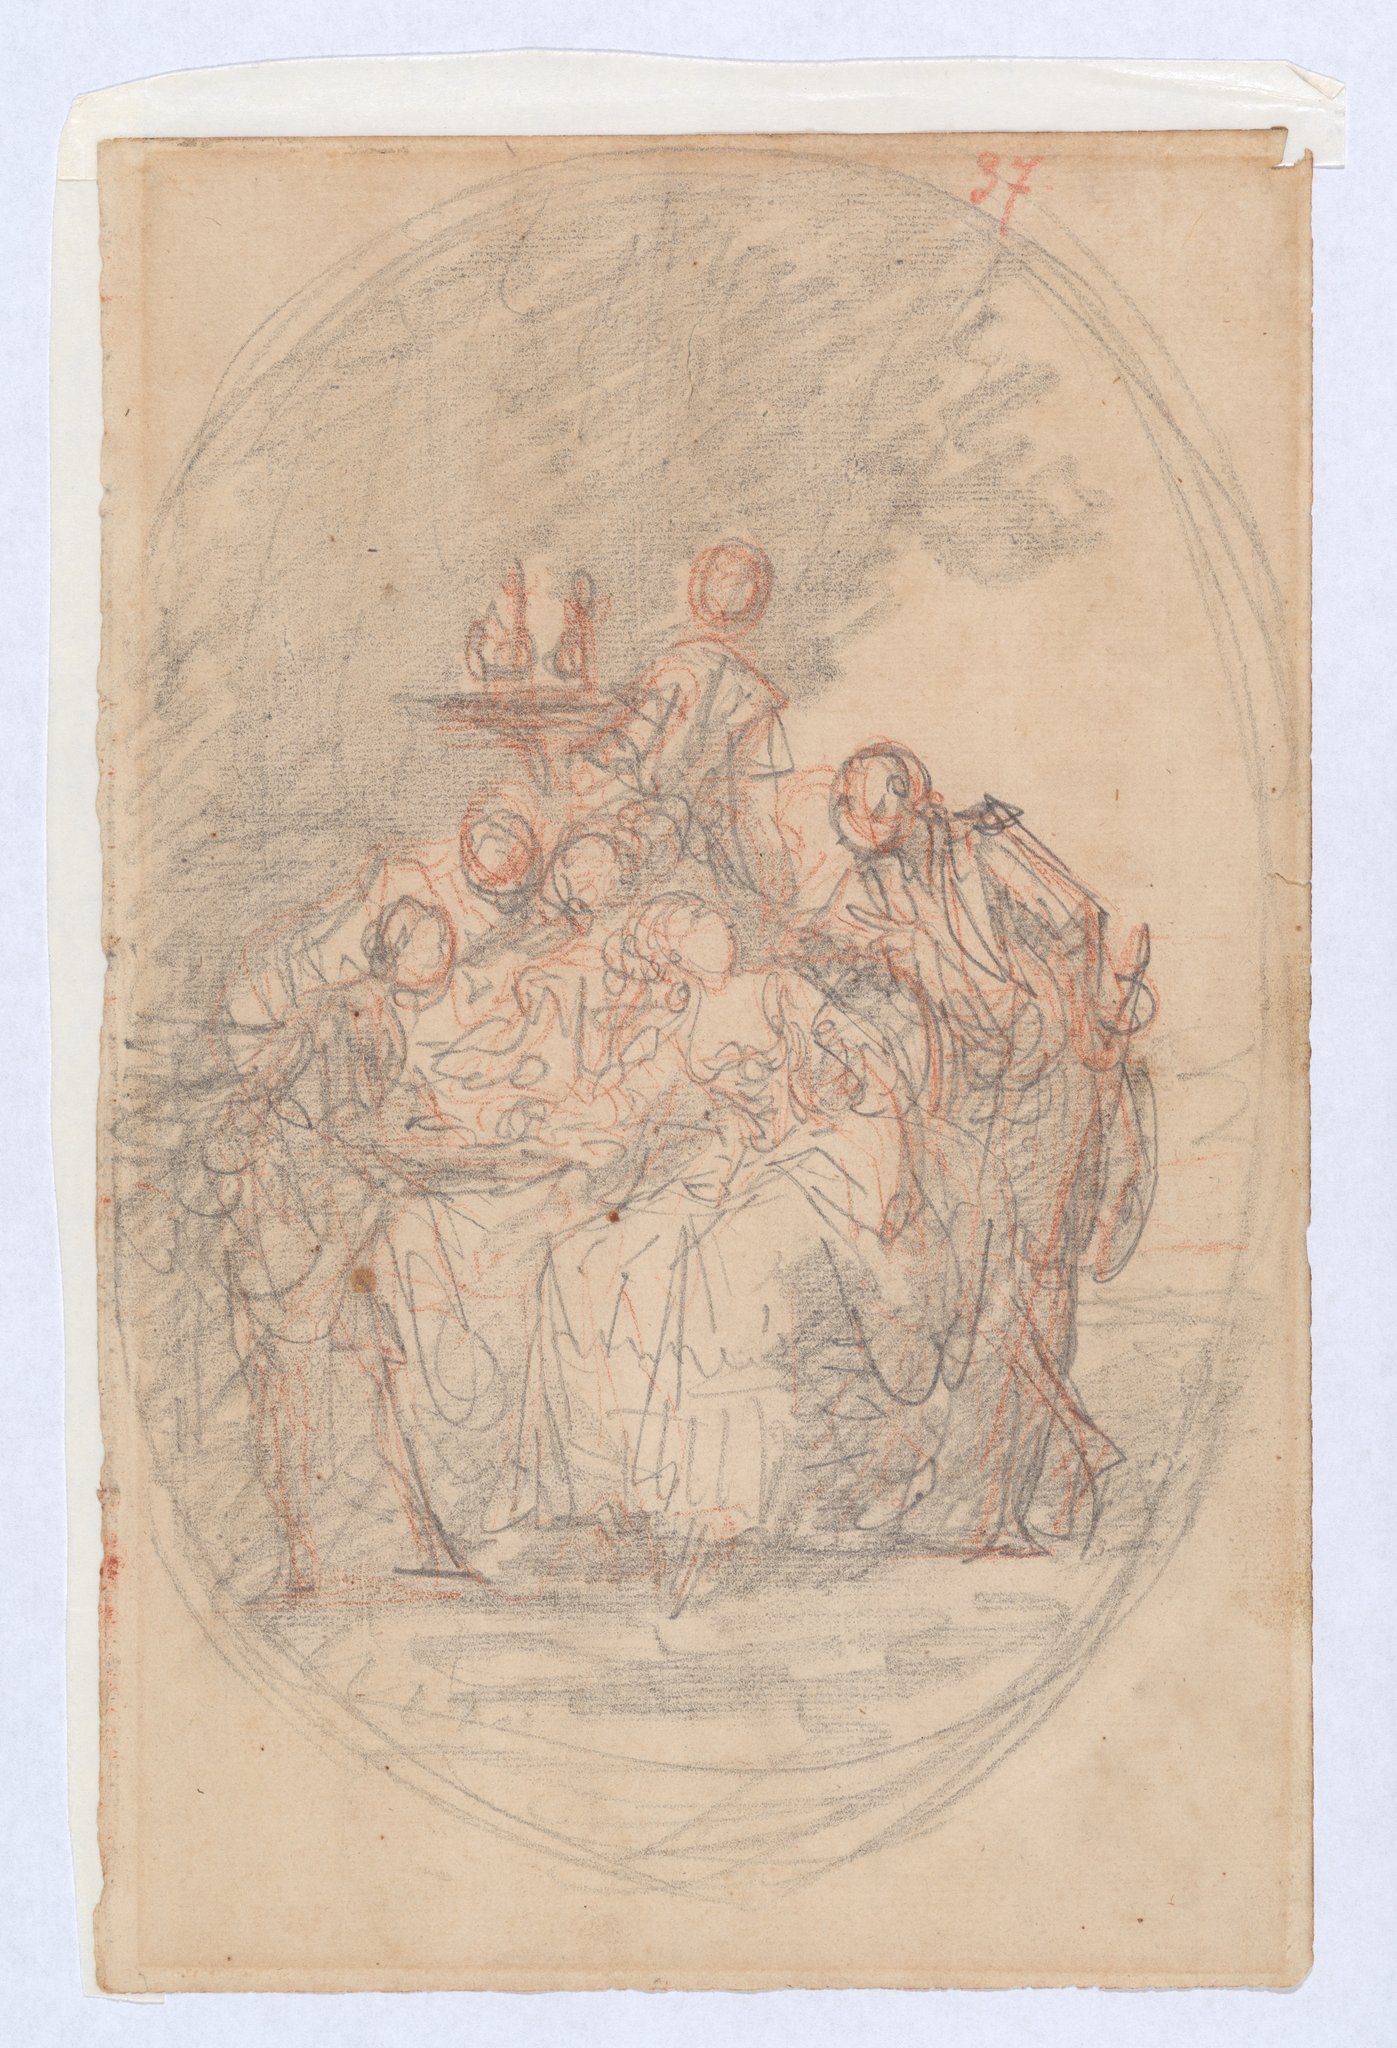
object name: drawing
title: An Outdoor Luncheon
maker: anonymous, french, 18th century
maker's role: artist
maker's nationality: french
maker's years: 1700-1800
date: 1701-1800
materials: chalk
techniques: stumping